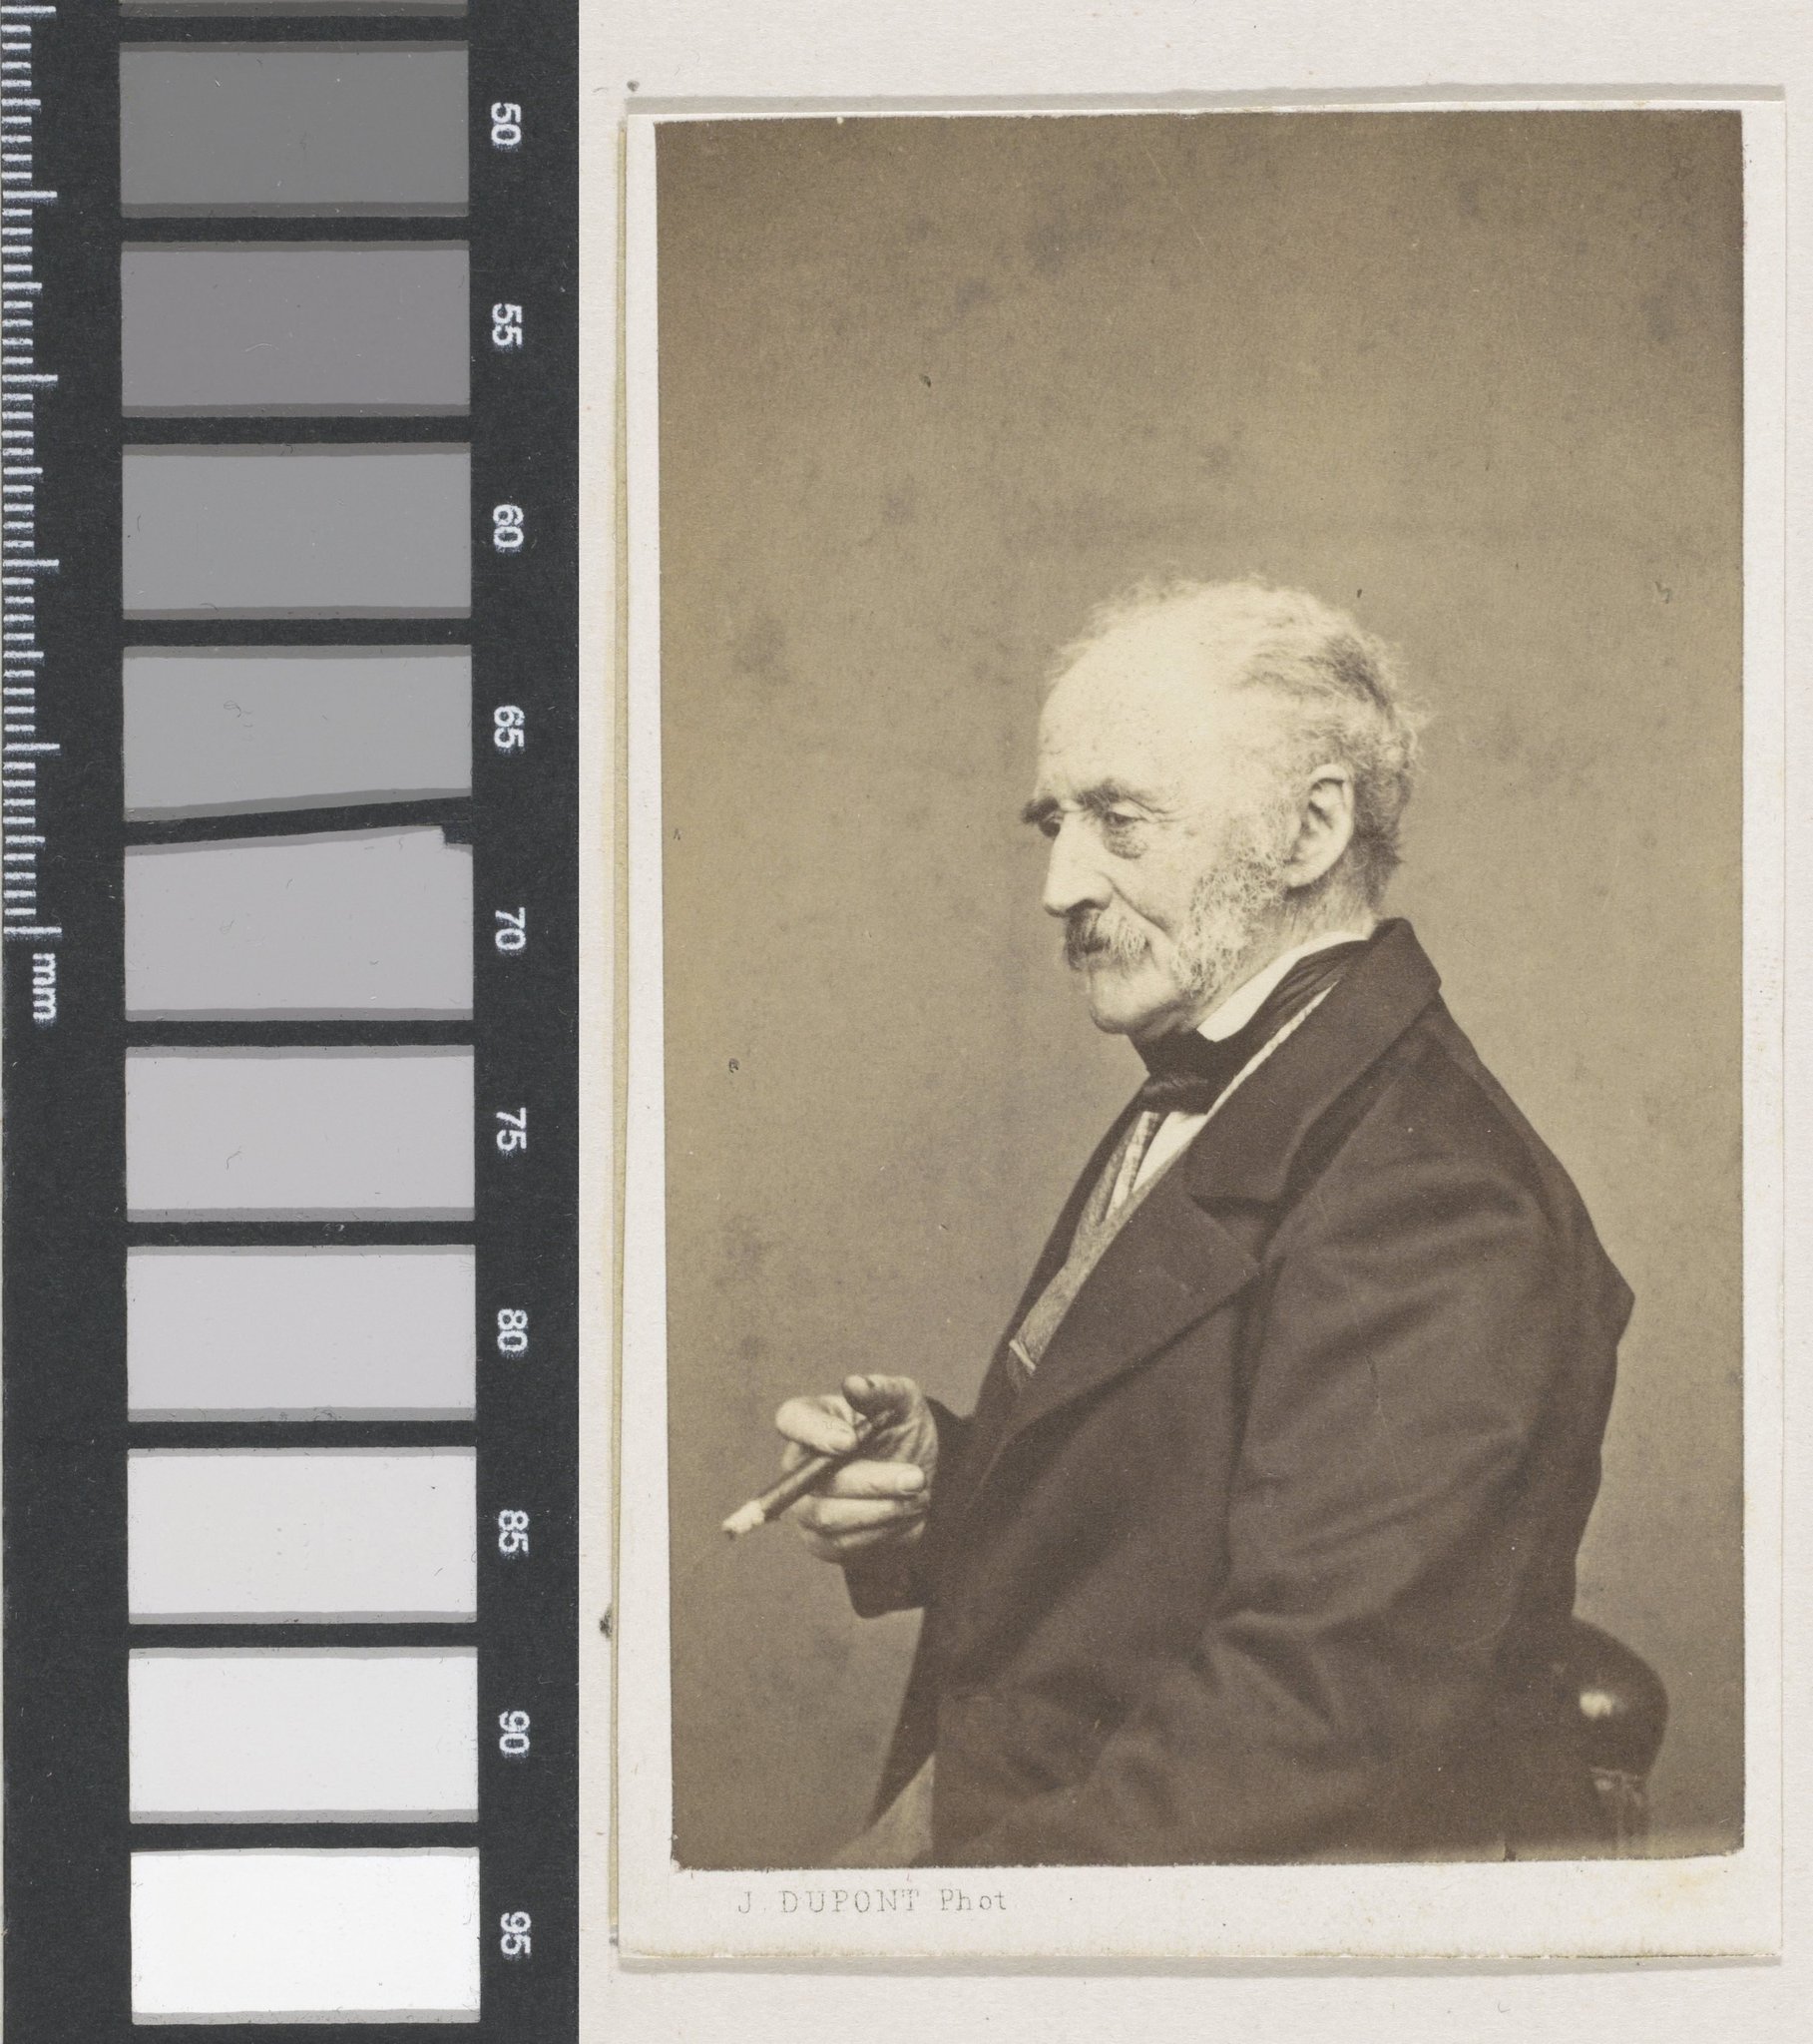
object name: carte de visite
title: Portret van de schilder Ignatius Josephus Van Regemorter, halffiguur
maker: joseph dupont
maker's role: fotograaf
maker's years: 1818-1901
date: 1861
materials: cardboard, paper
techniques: albumen print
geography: antwerp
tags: antwerp, painter, print maker, conservator, ignatius josephus van regemorter, historical persons, portrait, self-portrait of painter, portrait, self-portrait of artist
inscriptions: inscription: ‘ETABLISSEMENT PHOTOGRAPHIQUE/ de/ J. DUPONT/ Place de Meir 32/ ANVERS/ Maison fondée en 1853’